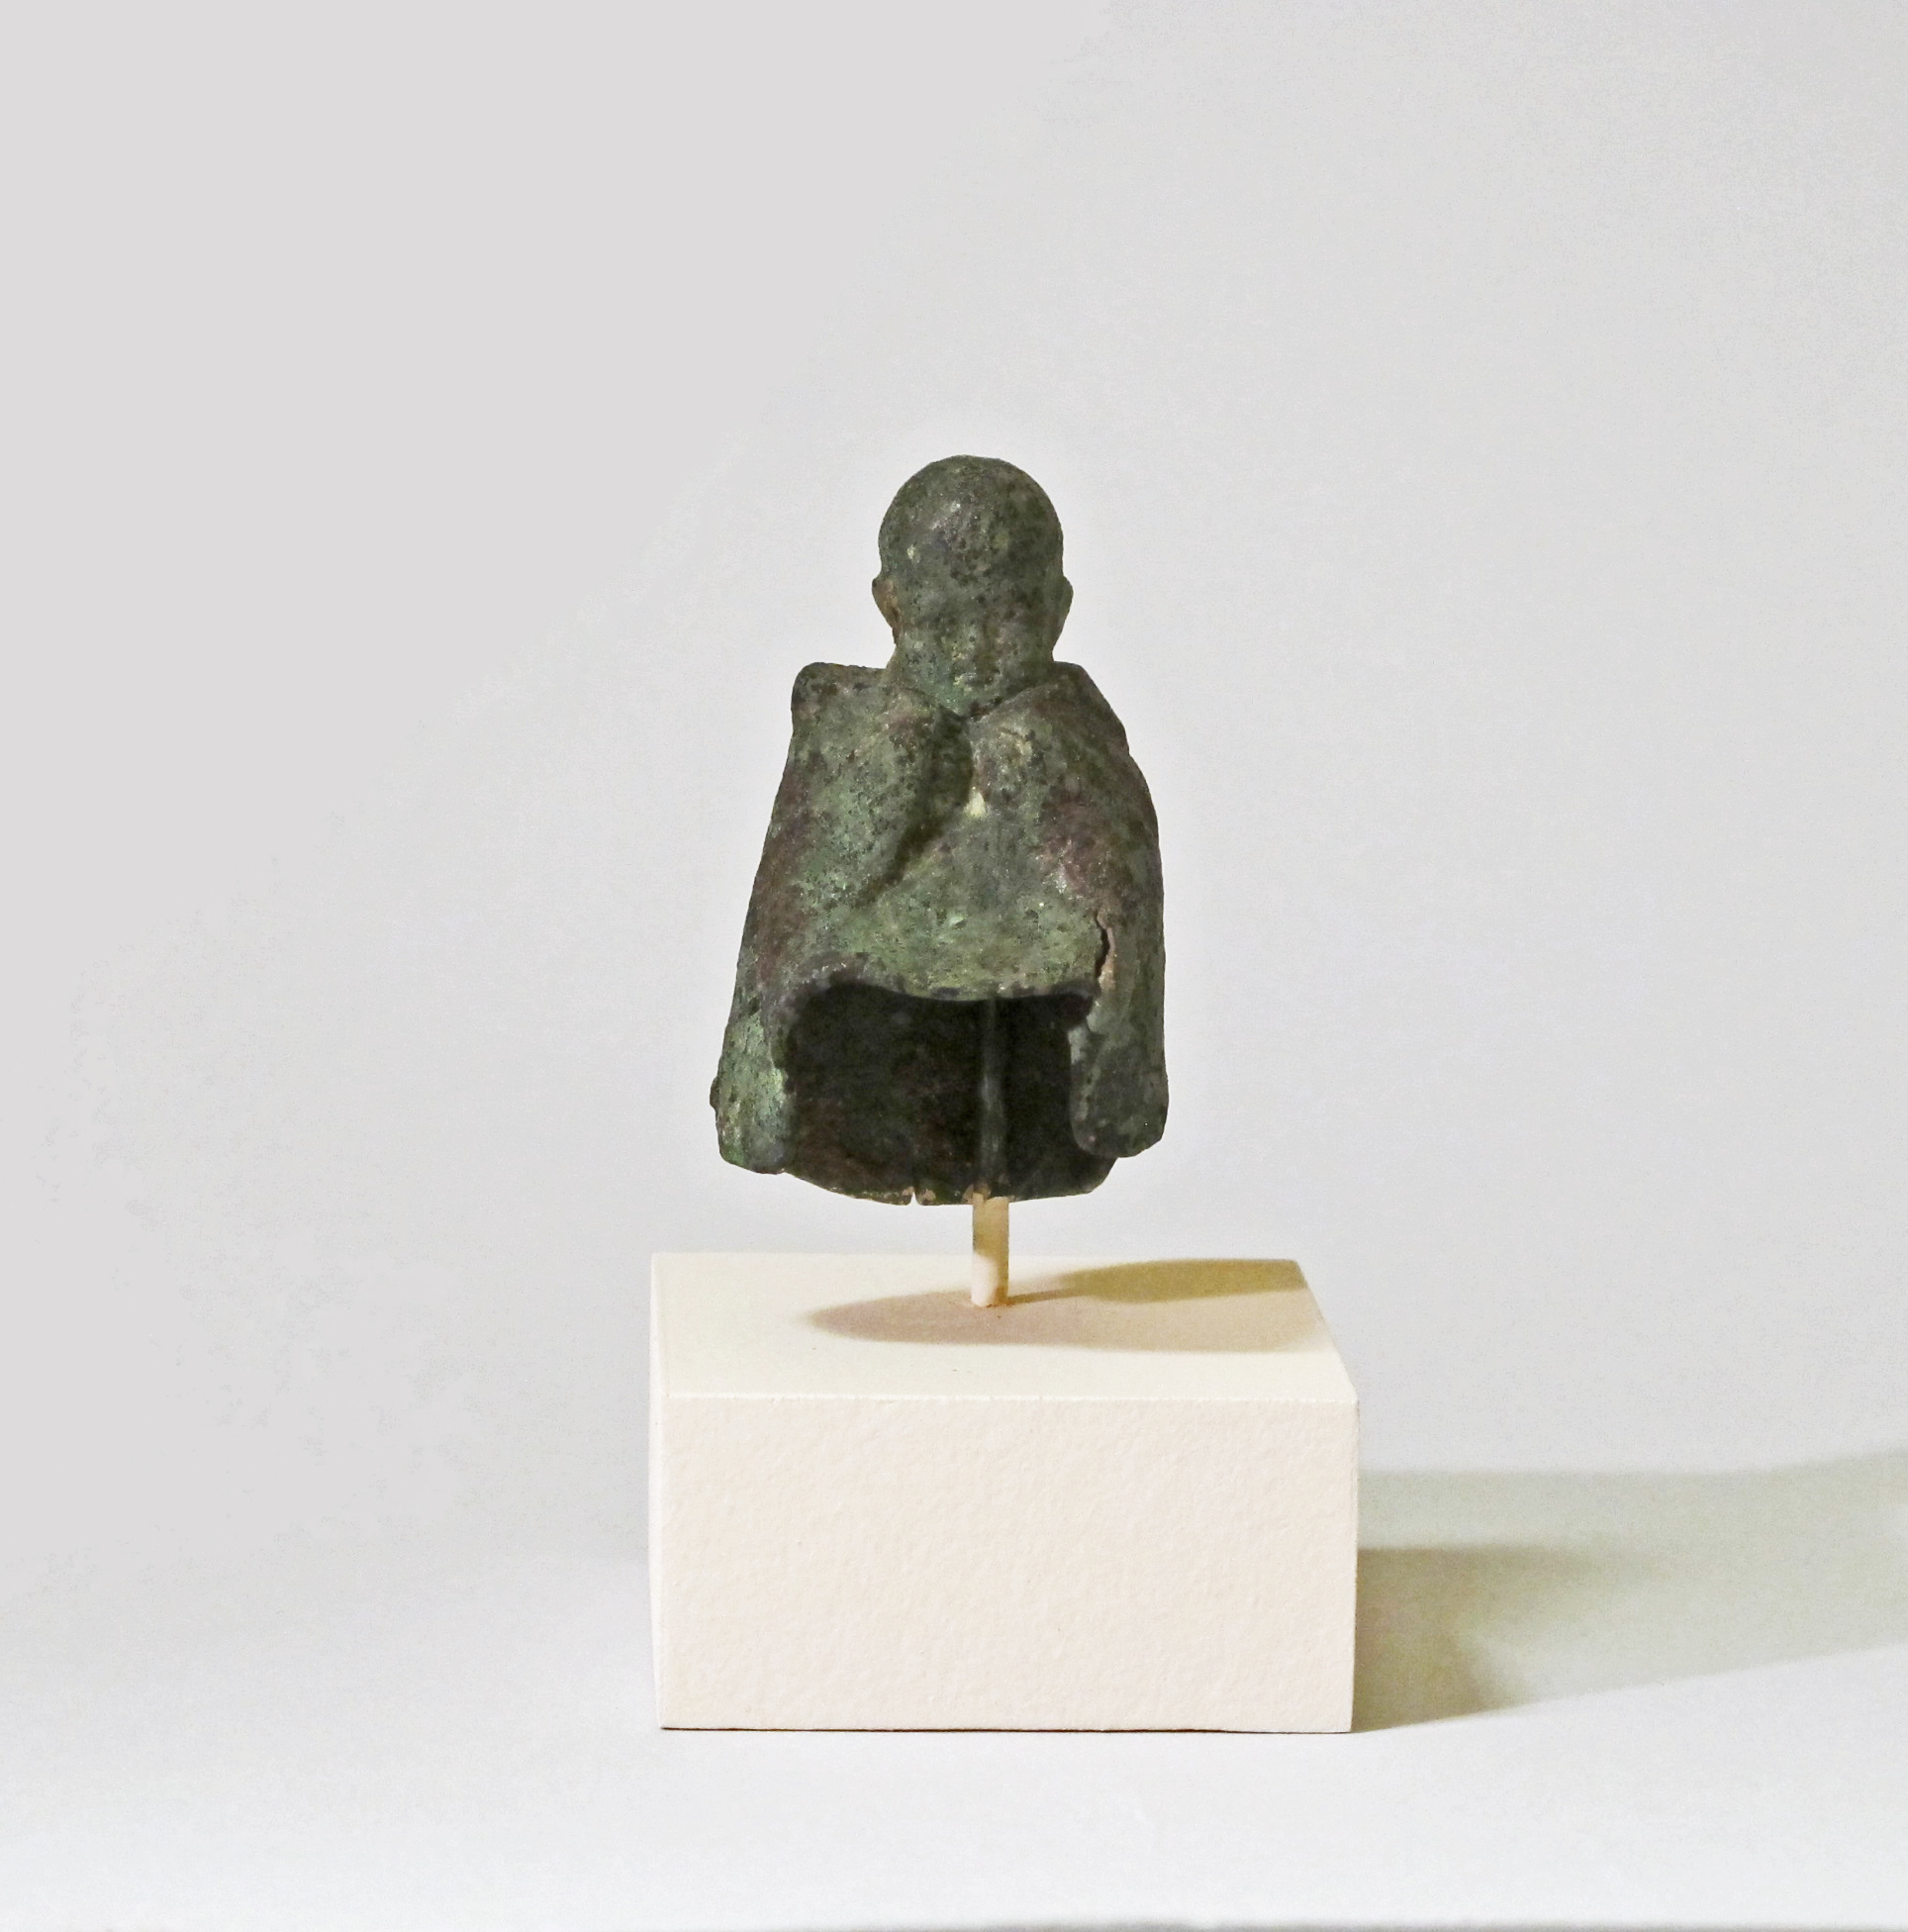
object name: statuette of a boy, upper part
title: Fragmentary bronze statuette of boy wearing a mantle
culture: roman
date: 1-200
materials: bronze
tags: boys